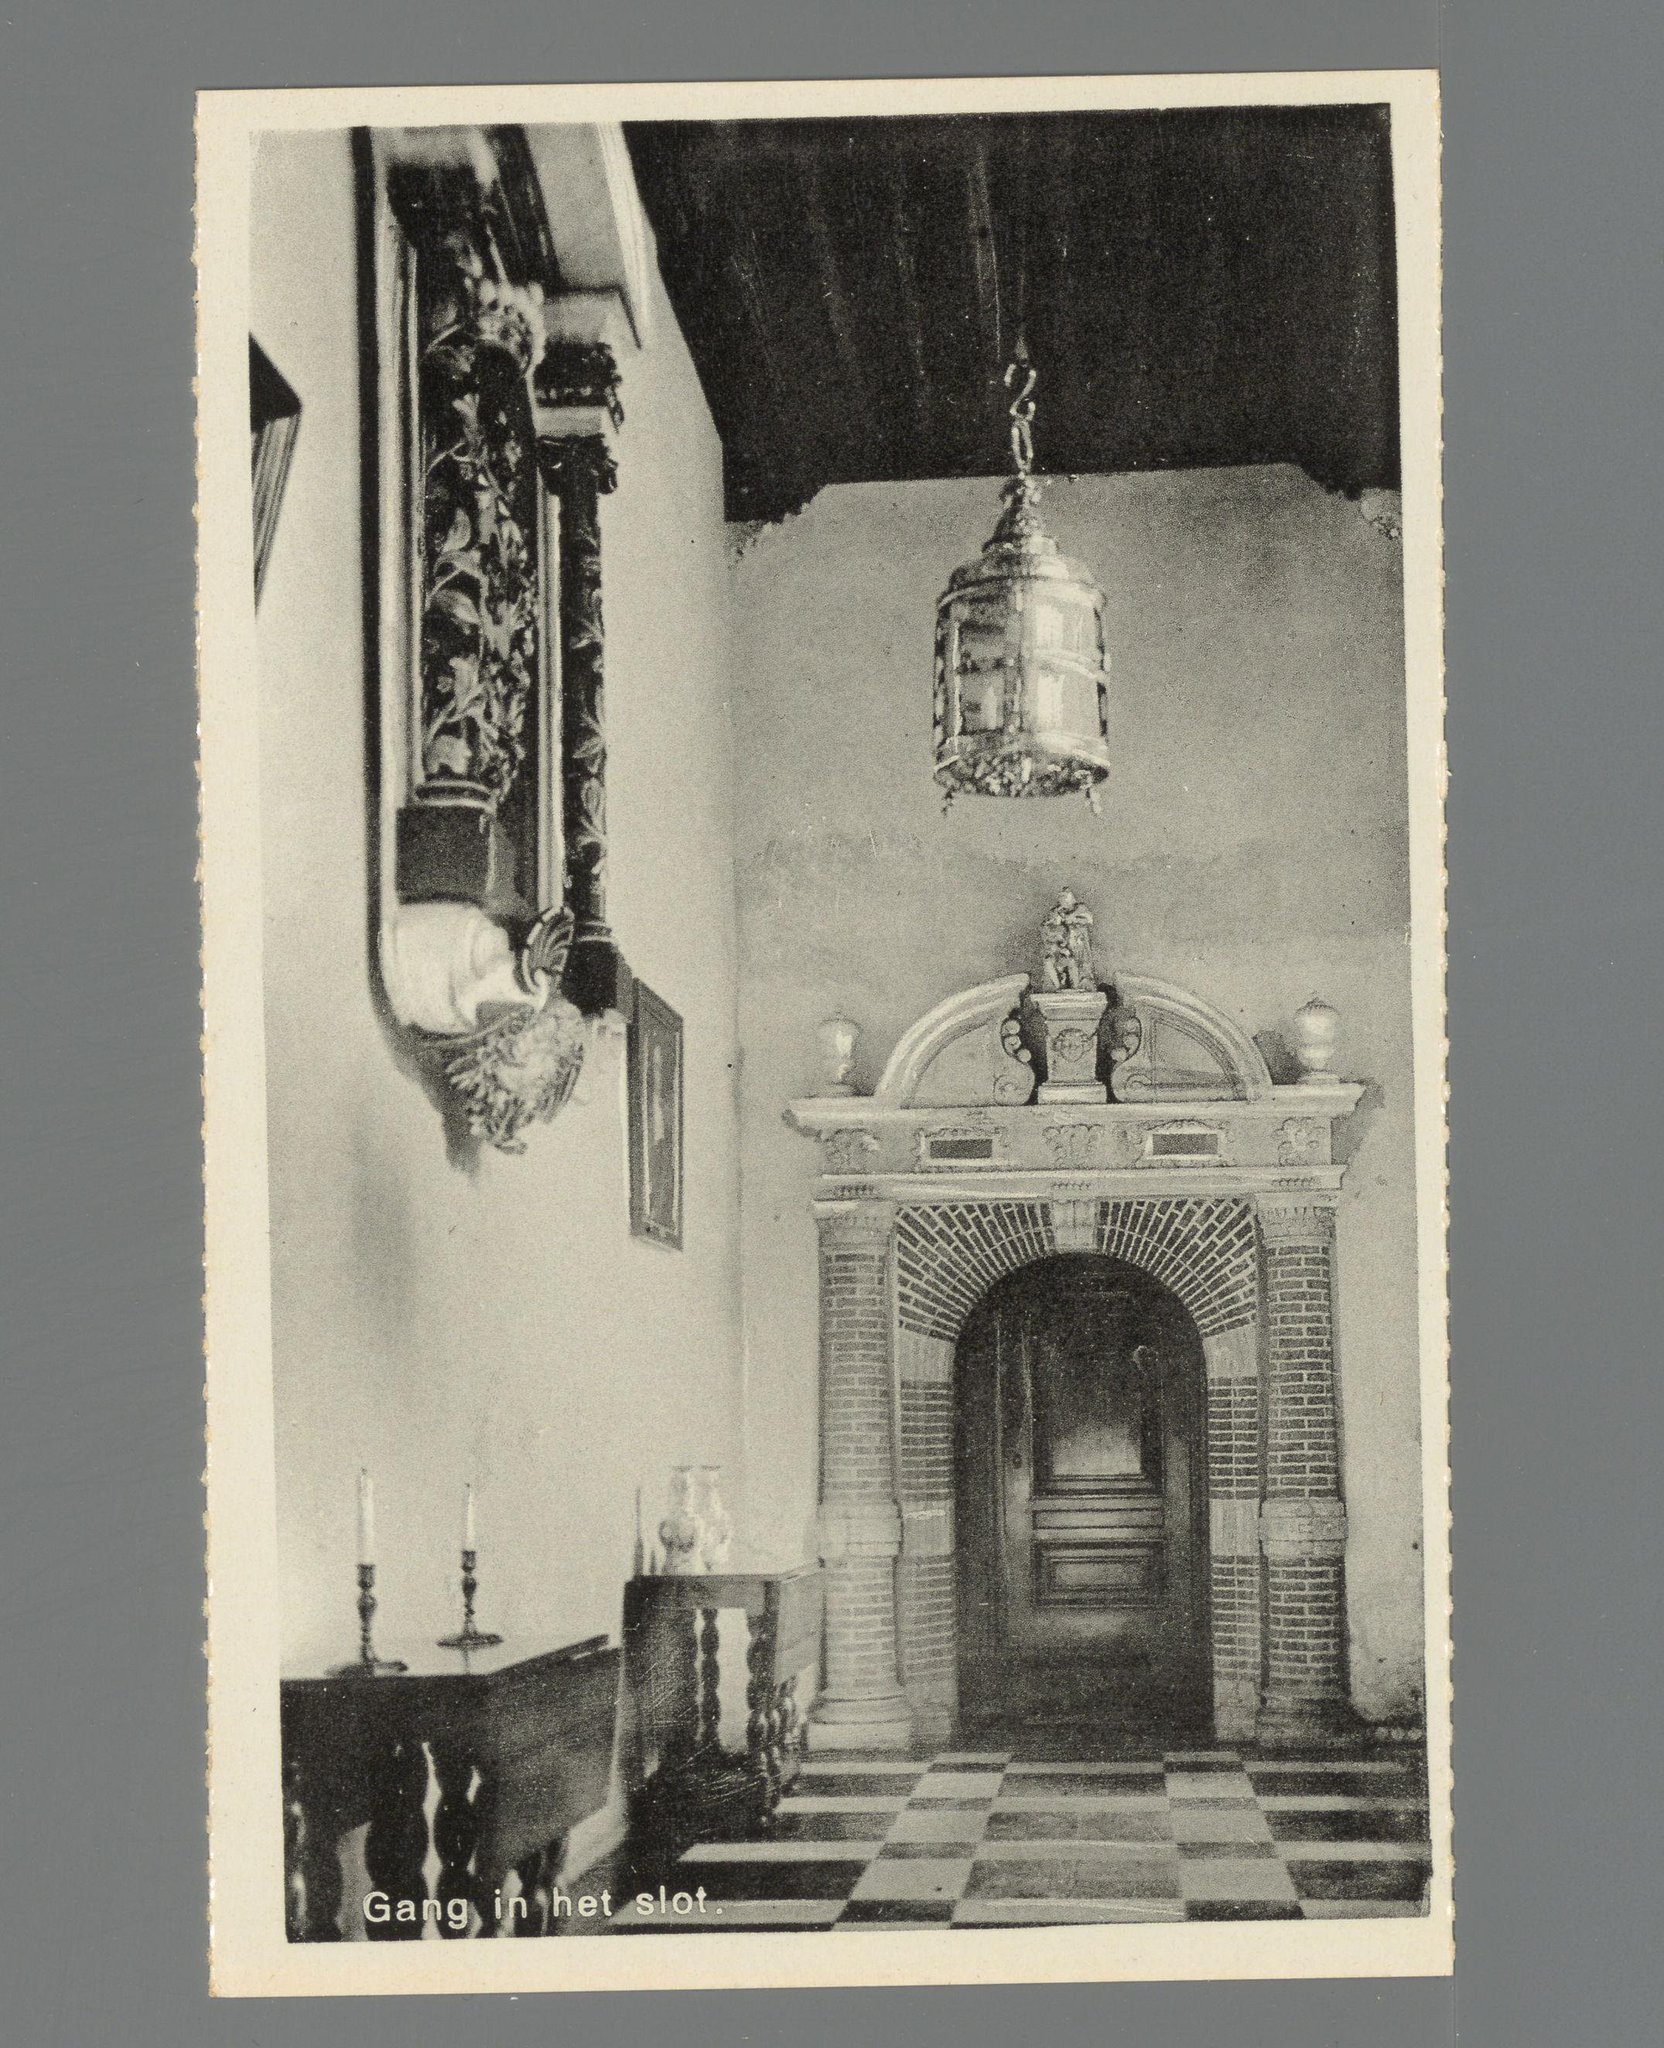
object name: ansichtkaart, prentbriefkaart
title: Gang in het slot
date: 1913-1950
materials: cardboard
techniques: photograph, writing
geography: marssum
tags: corridor, permanent exhibition, museum